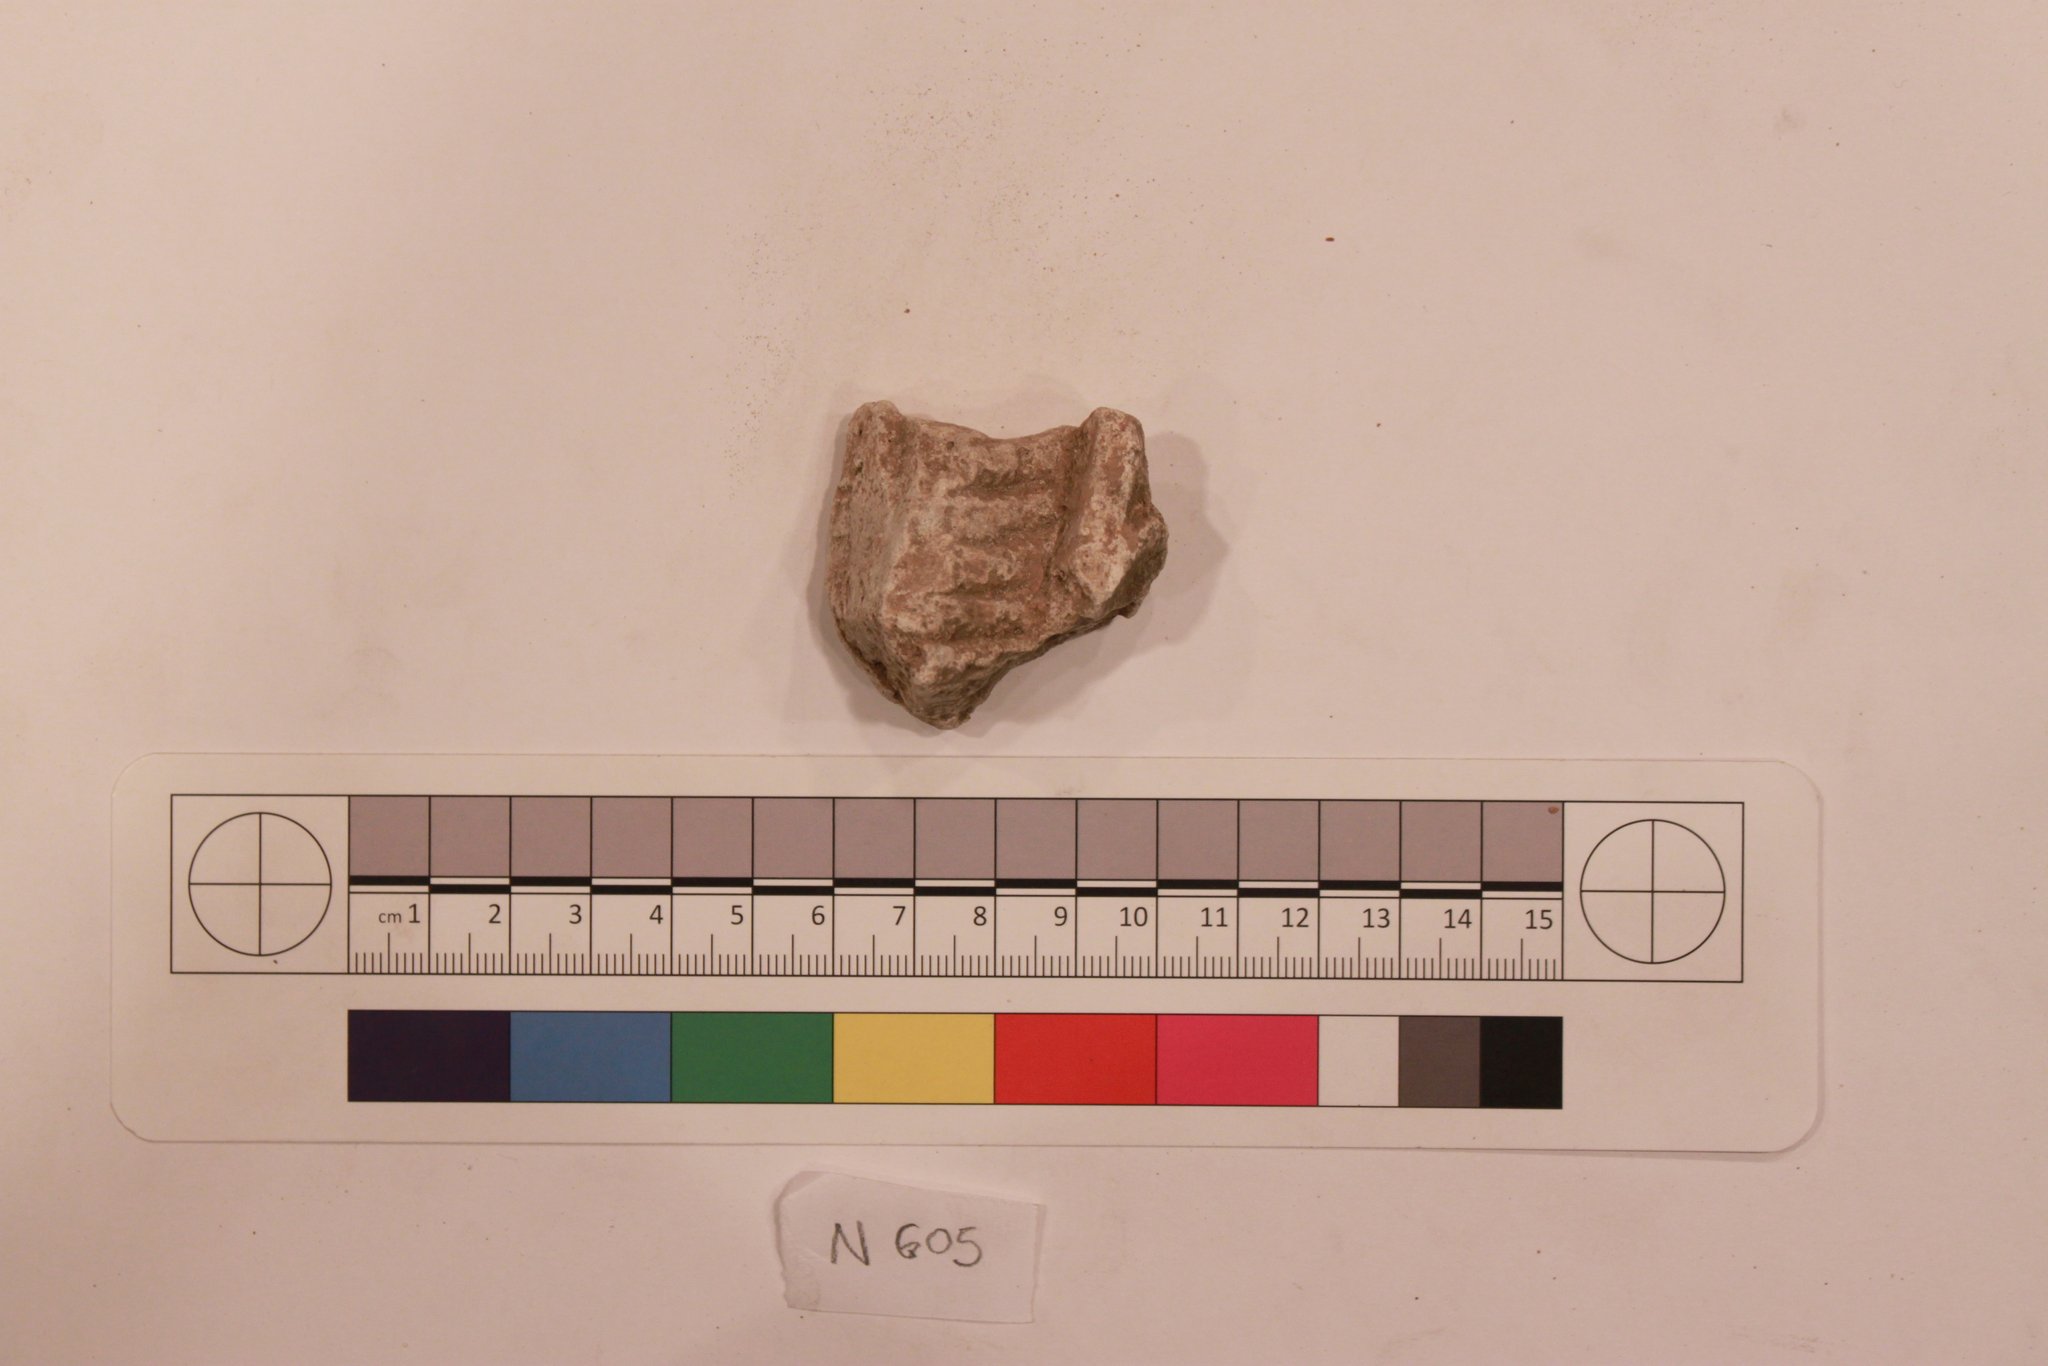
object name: fragment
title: Stucco Fragment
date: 701-1200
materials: plaster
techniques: carving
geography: iran